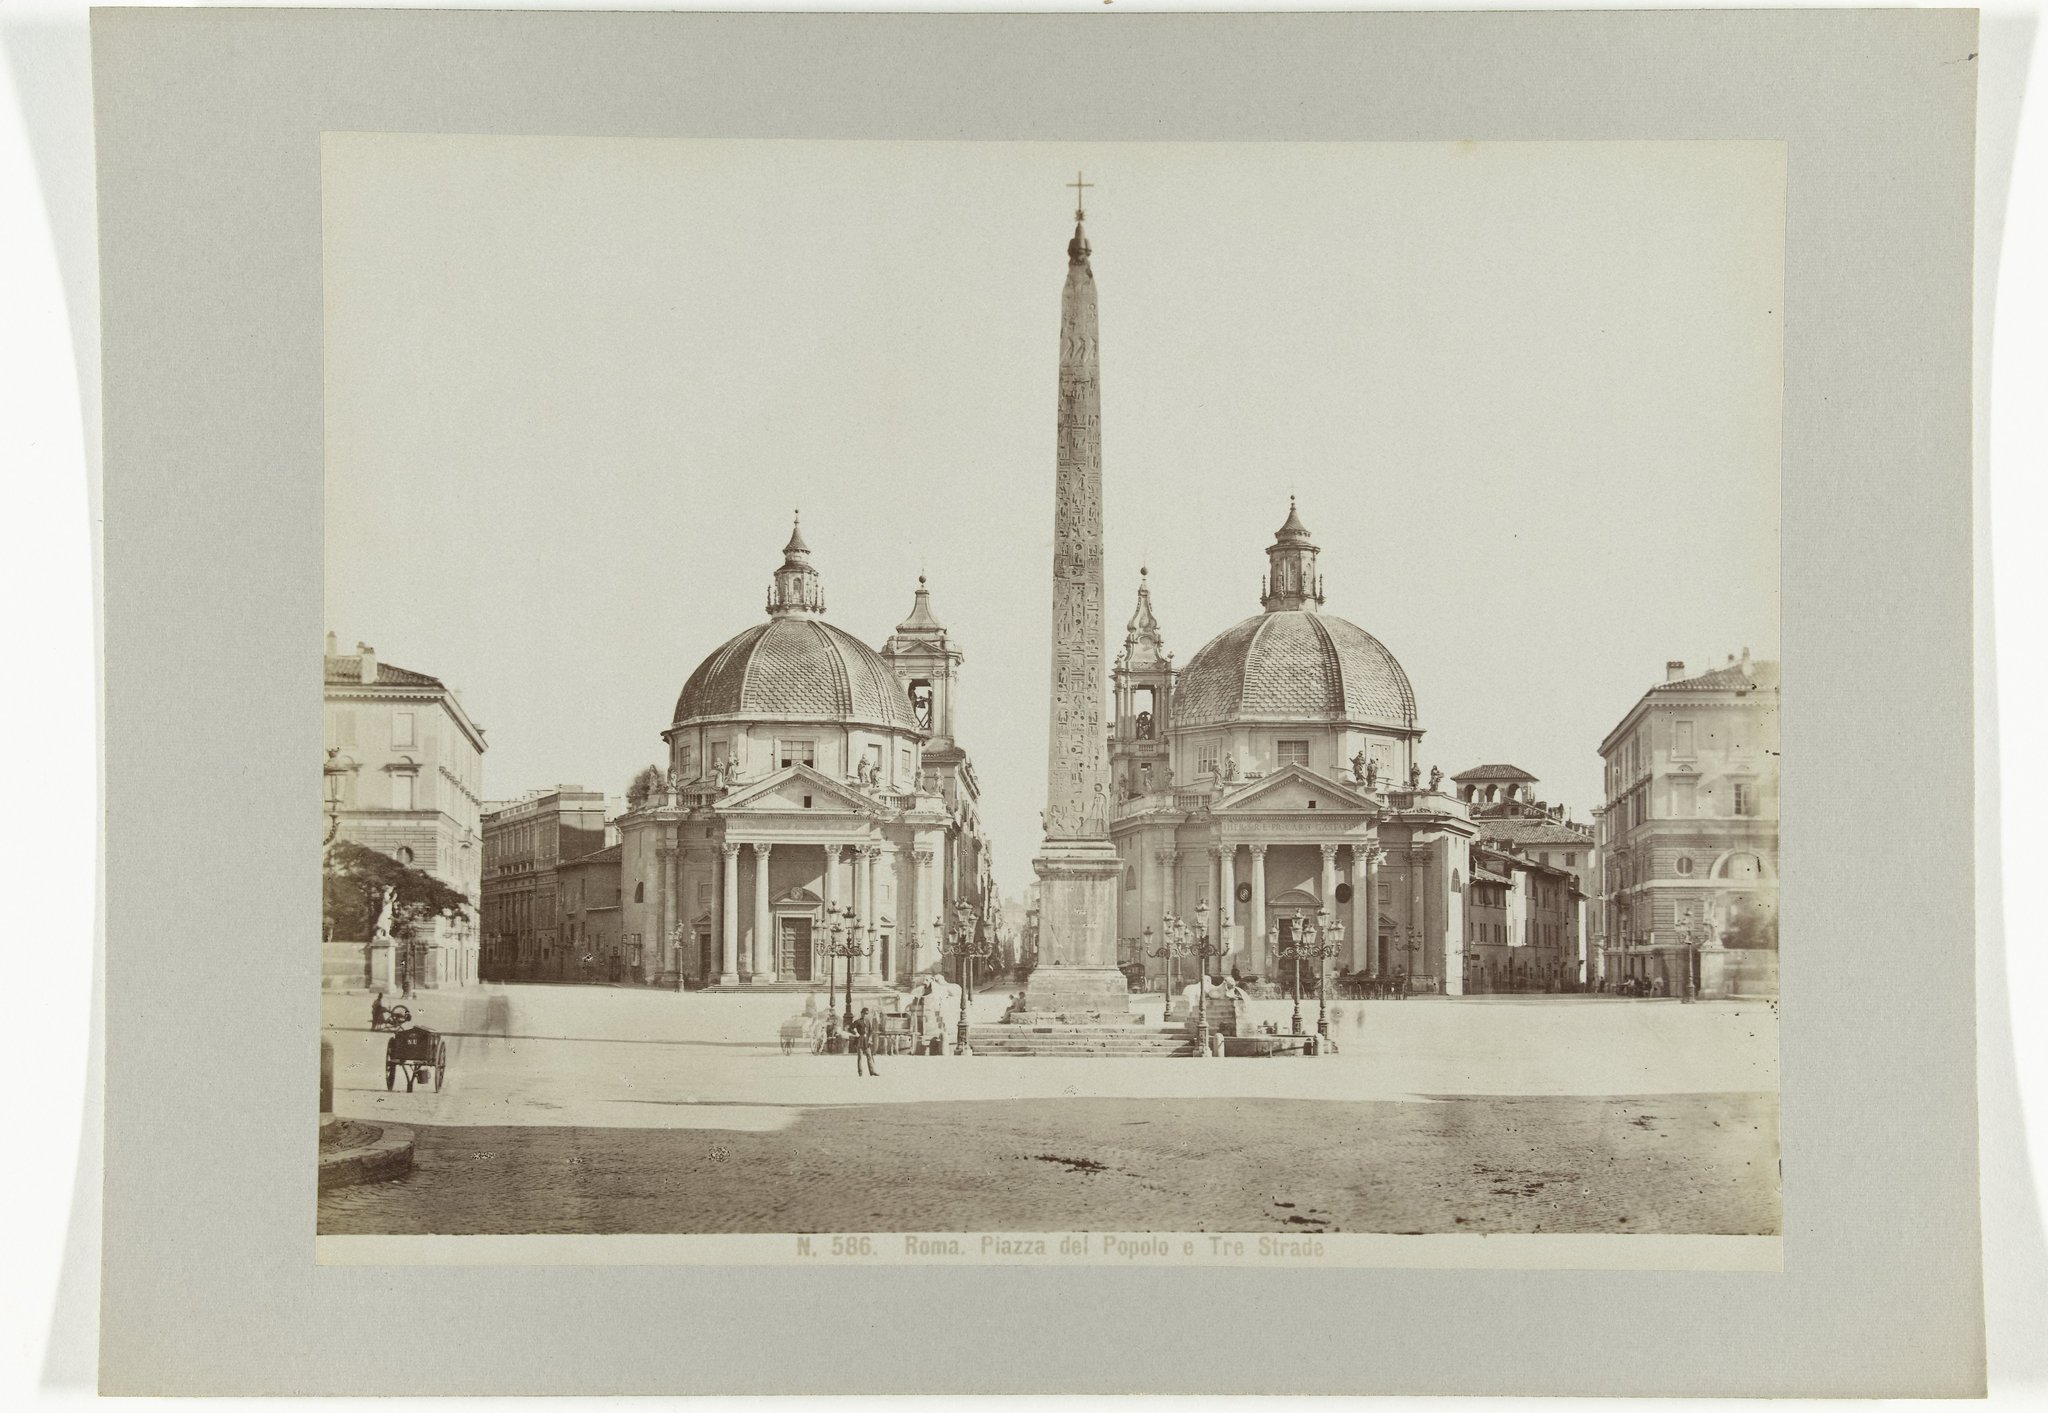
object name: photograph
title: Piazza del Popolo en drie straten, Rome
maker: Anonymous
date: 1880-1904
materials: cardboard, paper, photographic support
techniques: albumen print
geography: rome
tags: piazza del popolo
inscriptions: number: ‘44.’